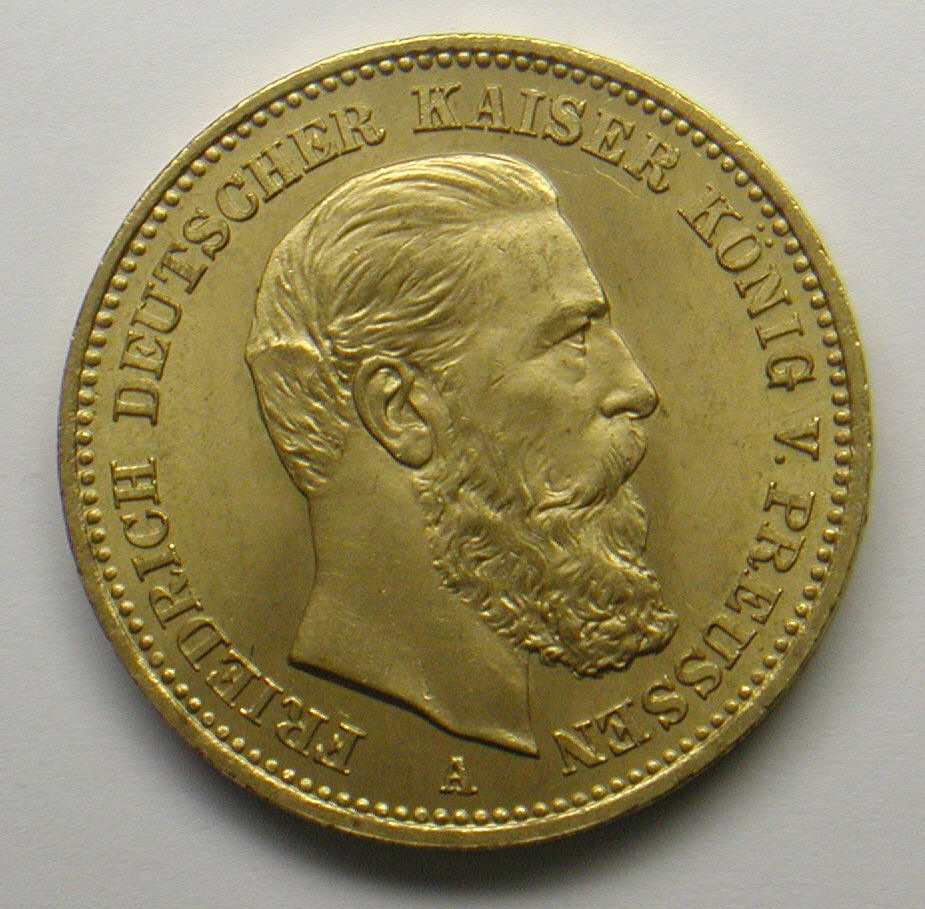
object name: mark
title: 20-mark piece, Frederick I, German Emperor, 1888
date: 1888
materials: gold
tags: men,profiles,coins,coat of arms